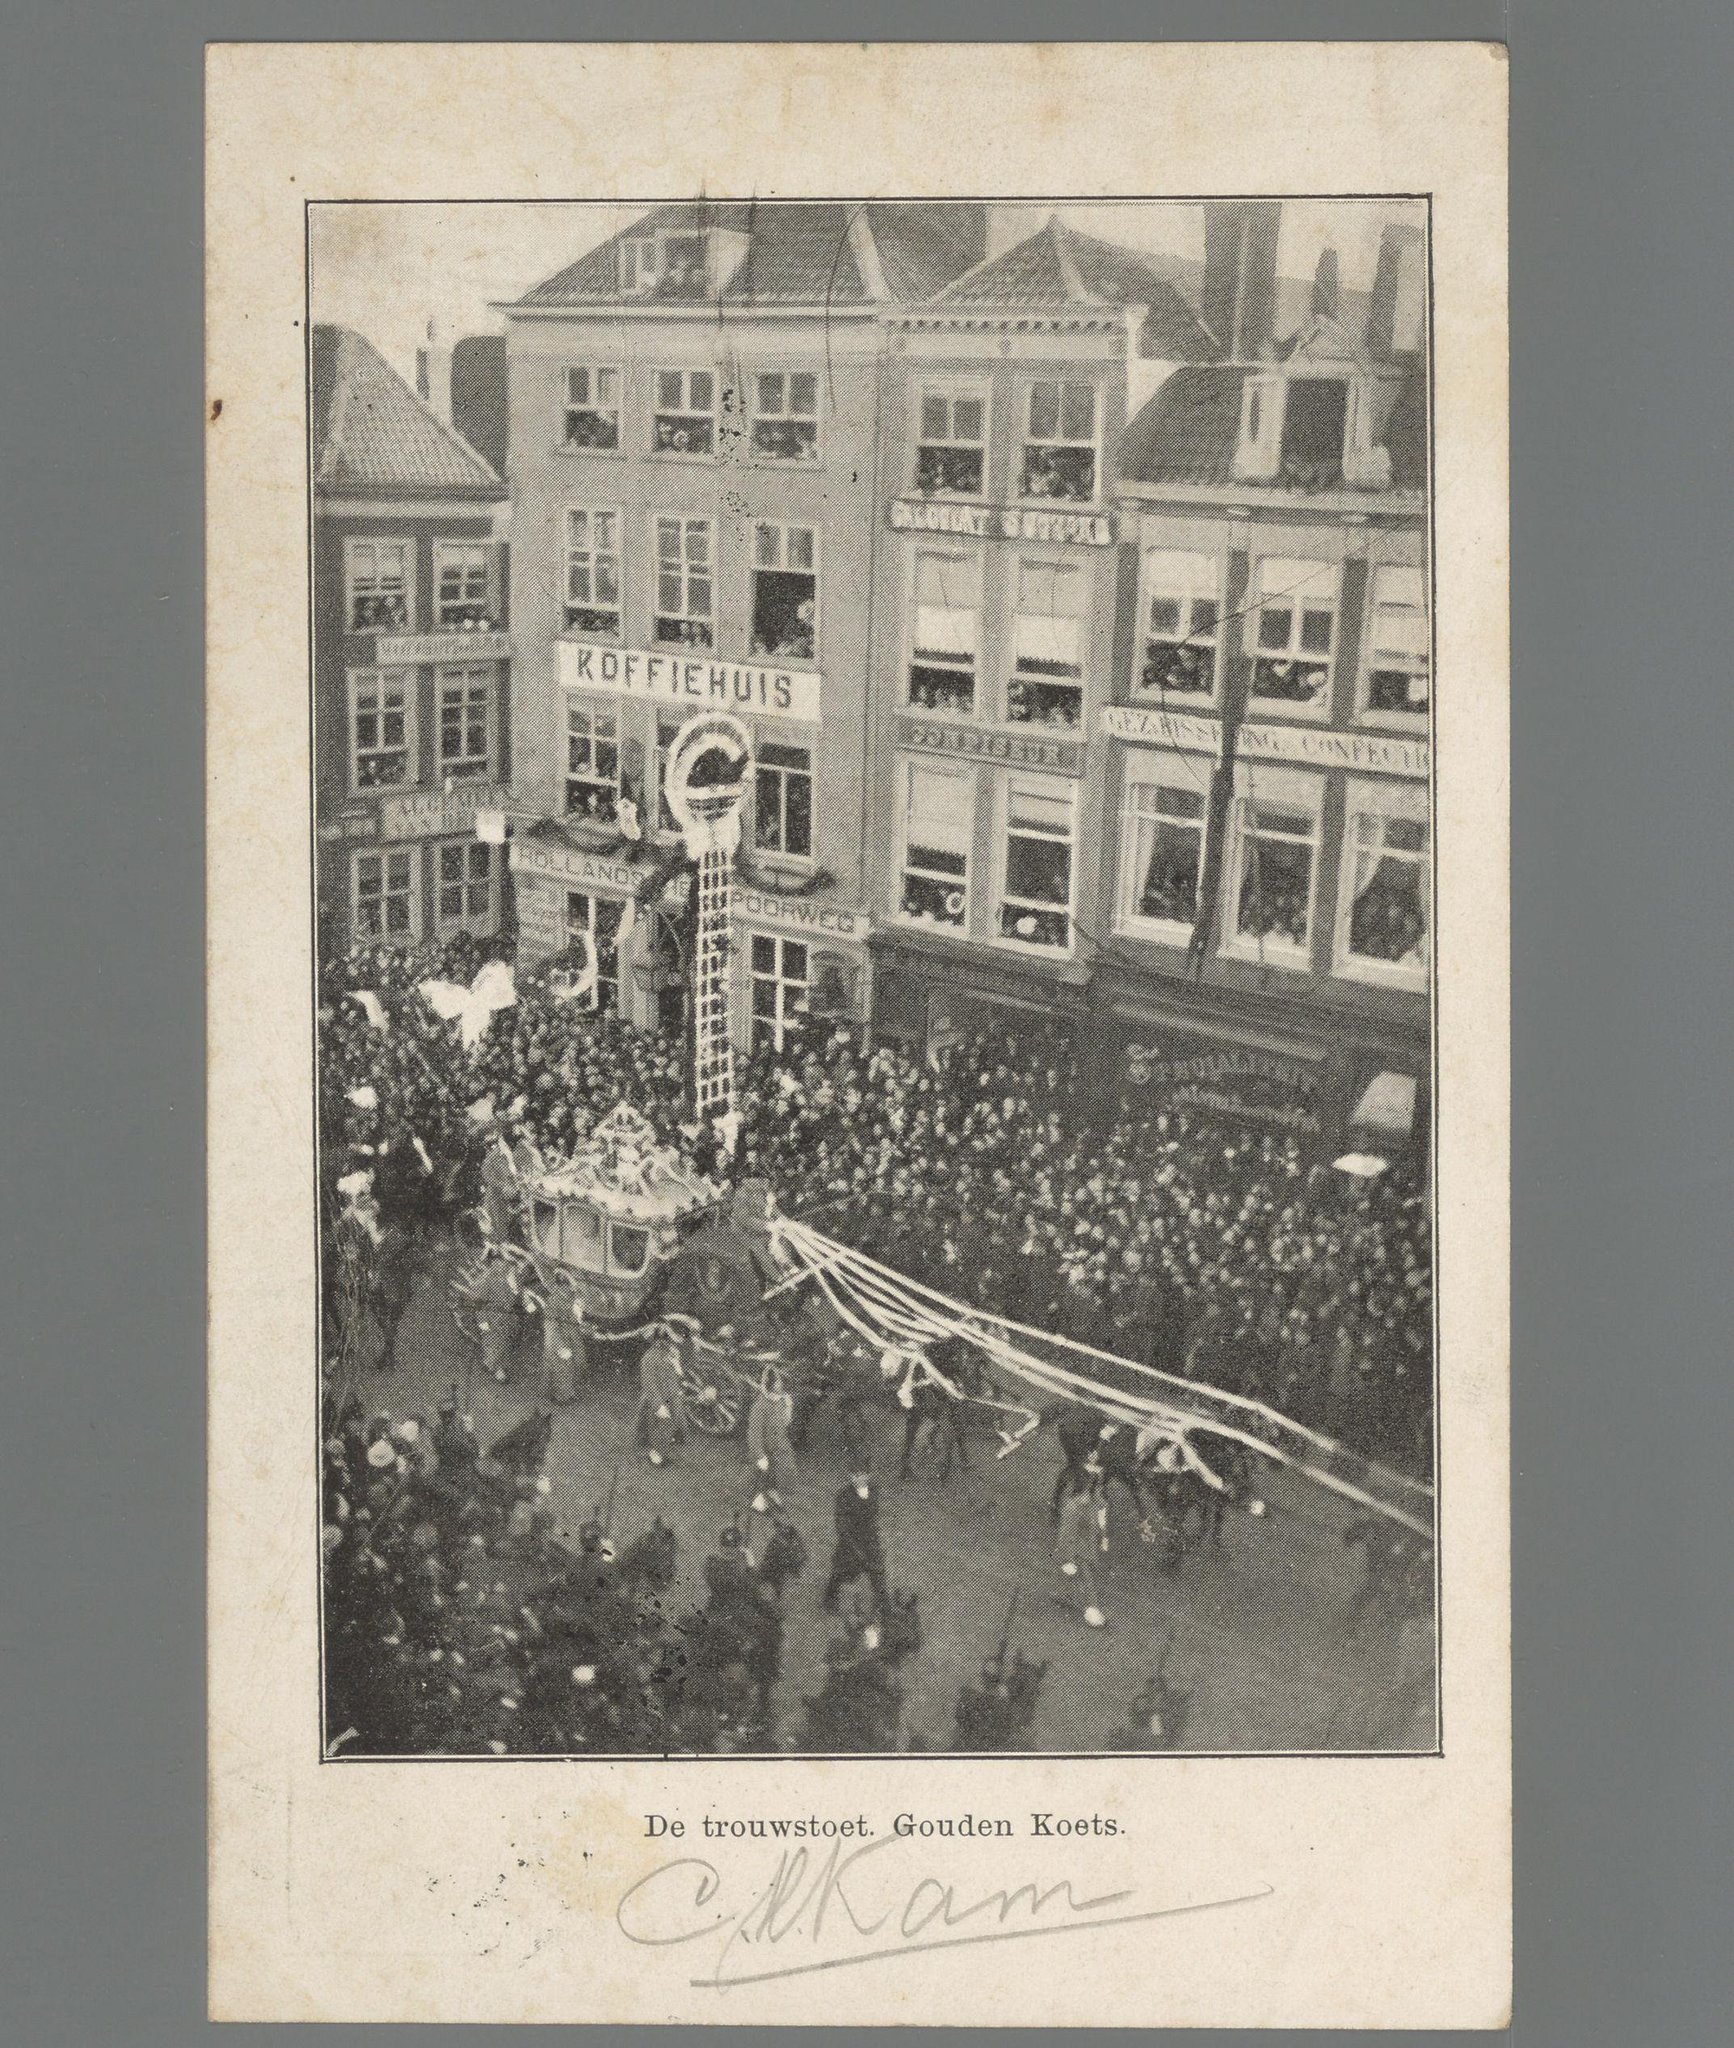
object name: ansichtkaart, prentbriefkaart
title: De trouwstoet. Gouden Koets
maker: Anonymous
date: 1901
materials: cardboard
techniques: writing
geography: the hague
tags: four-wheeled, animal-drawn vehicle, e.g.: cab, carriage, coach, public festivities, city-view, and landscape with man-made constructions (+ city(-scape) with figures, staffage), the hague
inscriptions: postage stamp